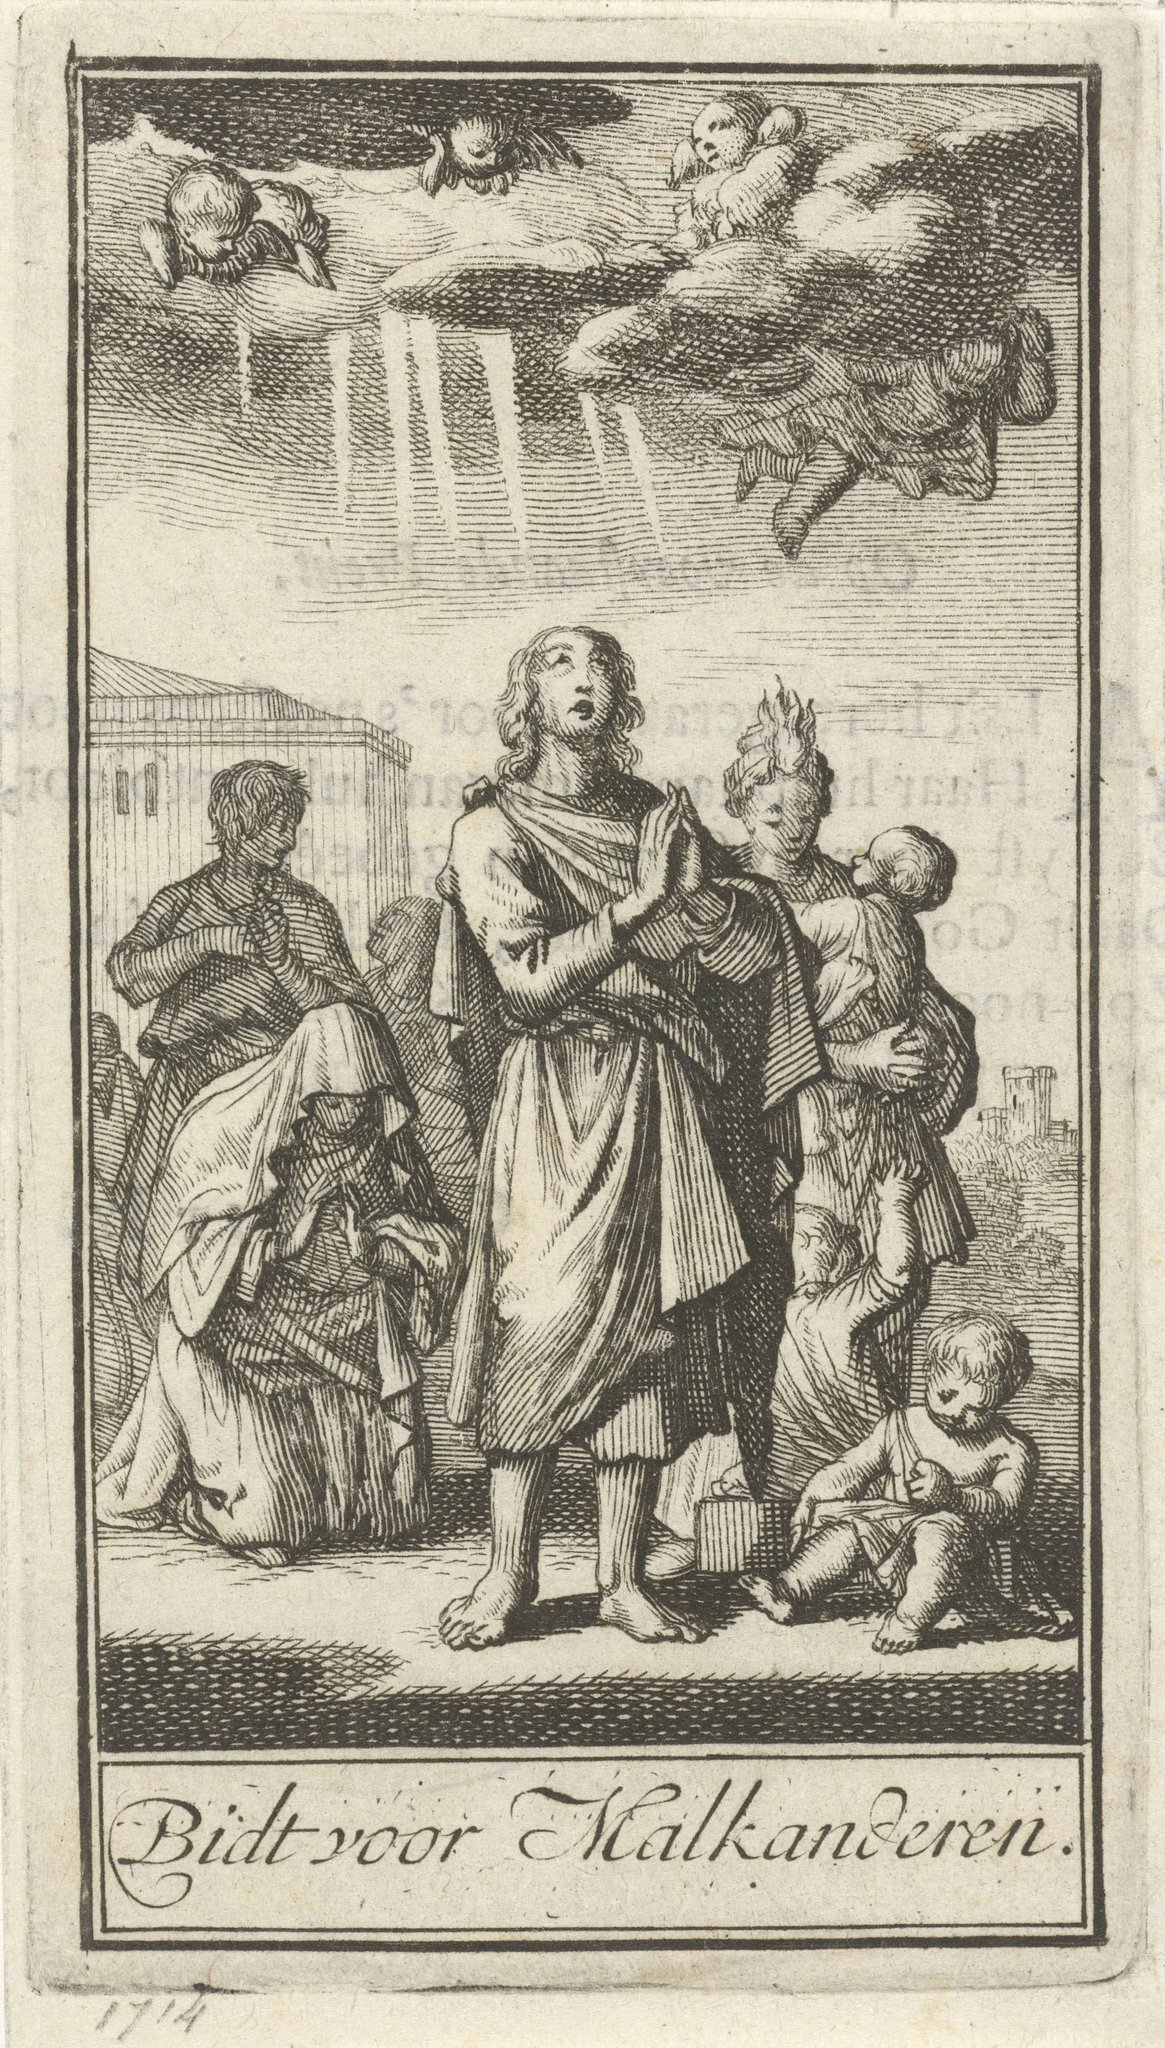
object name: print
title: Bidt voor Malkanderen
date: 1714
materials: paper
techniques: etching, letterpress printing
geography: amsterdam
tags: one person praying, angels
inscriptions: collector's mark: Lugt 2228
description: Illustratie uit: Molinaeus, Johannes. Sleutel des hemels ofte Christelyk gebede-boek. Amsterdam: Barent Bos, 1714.